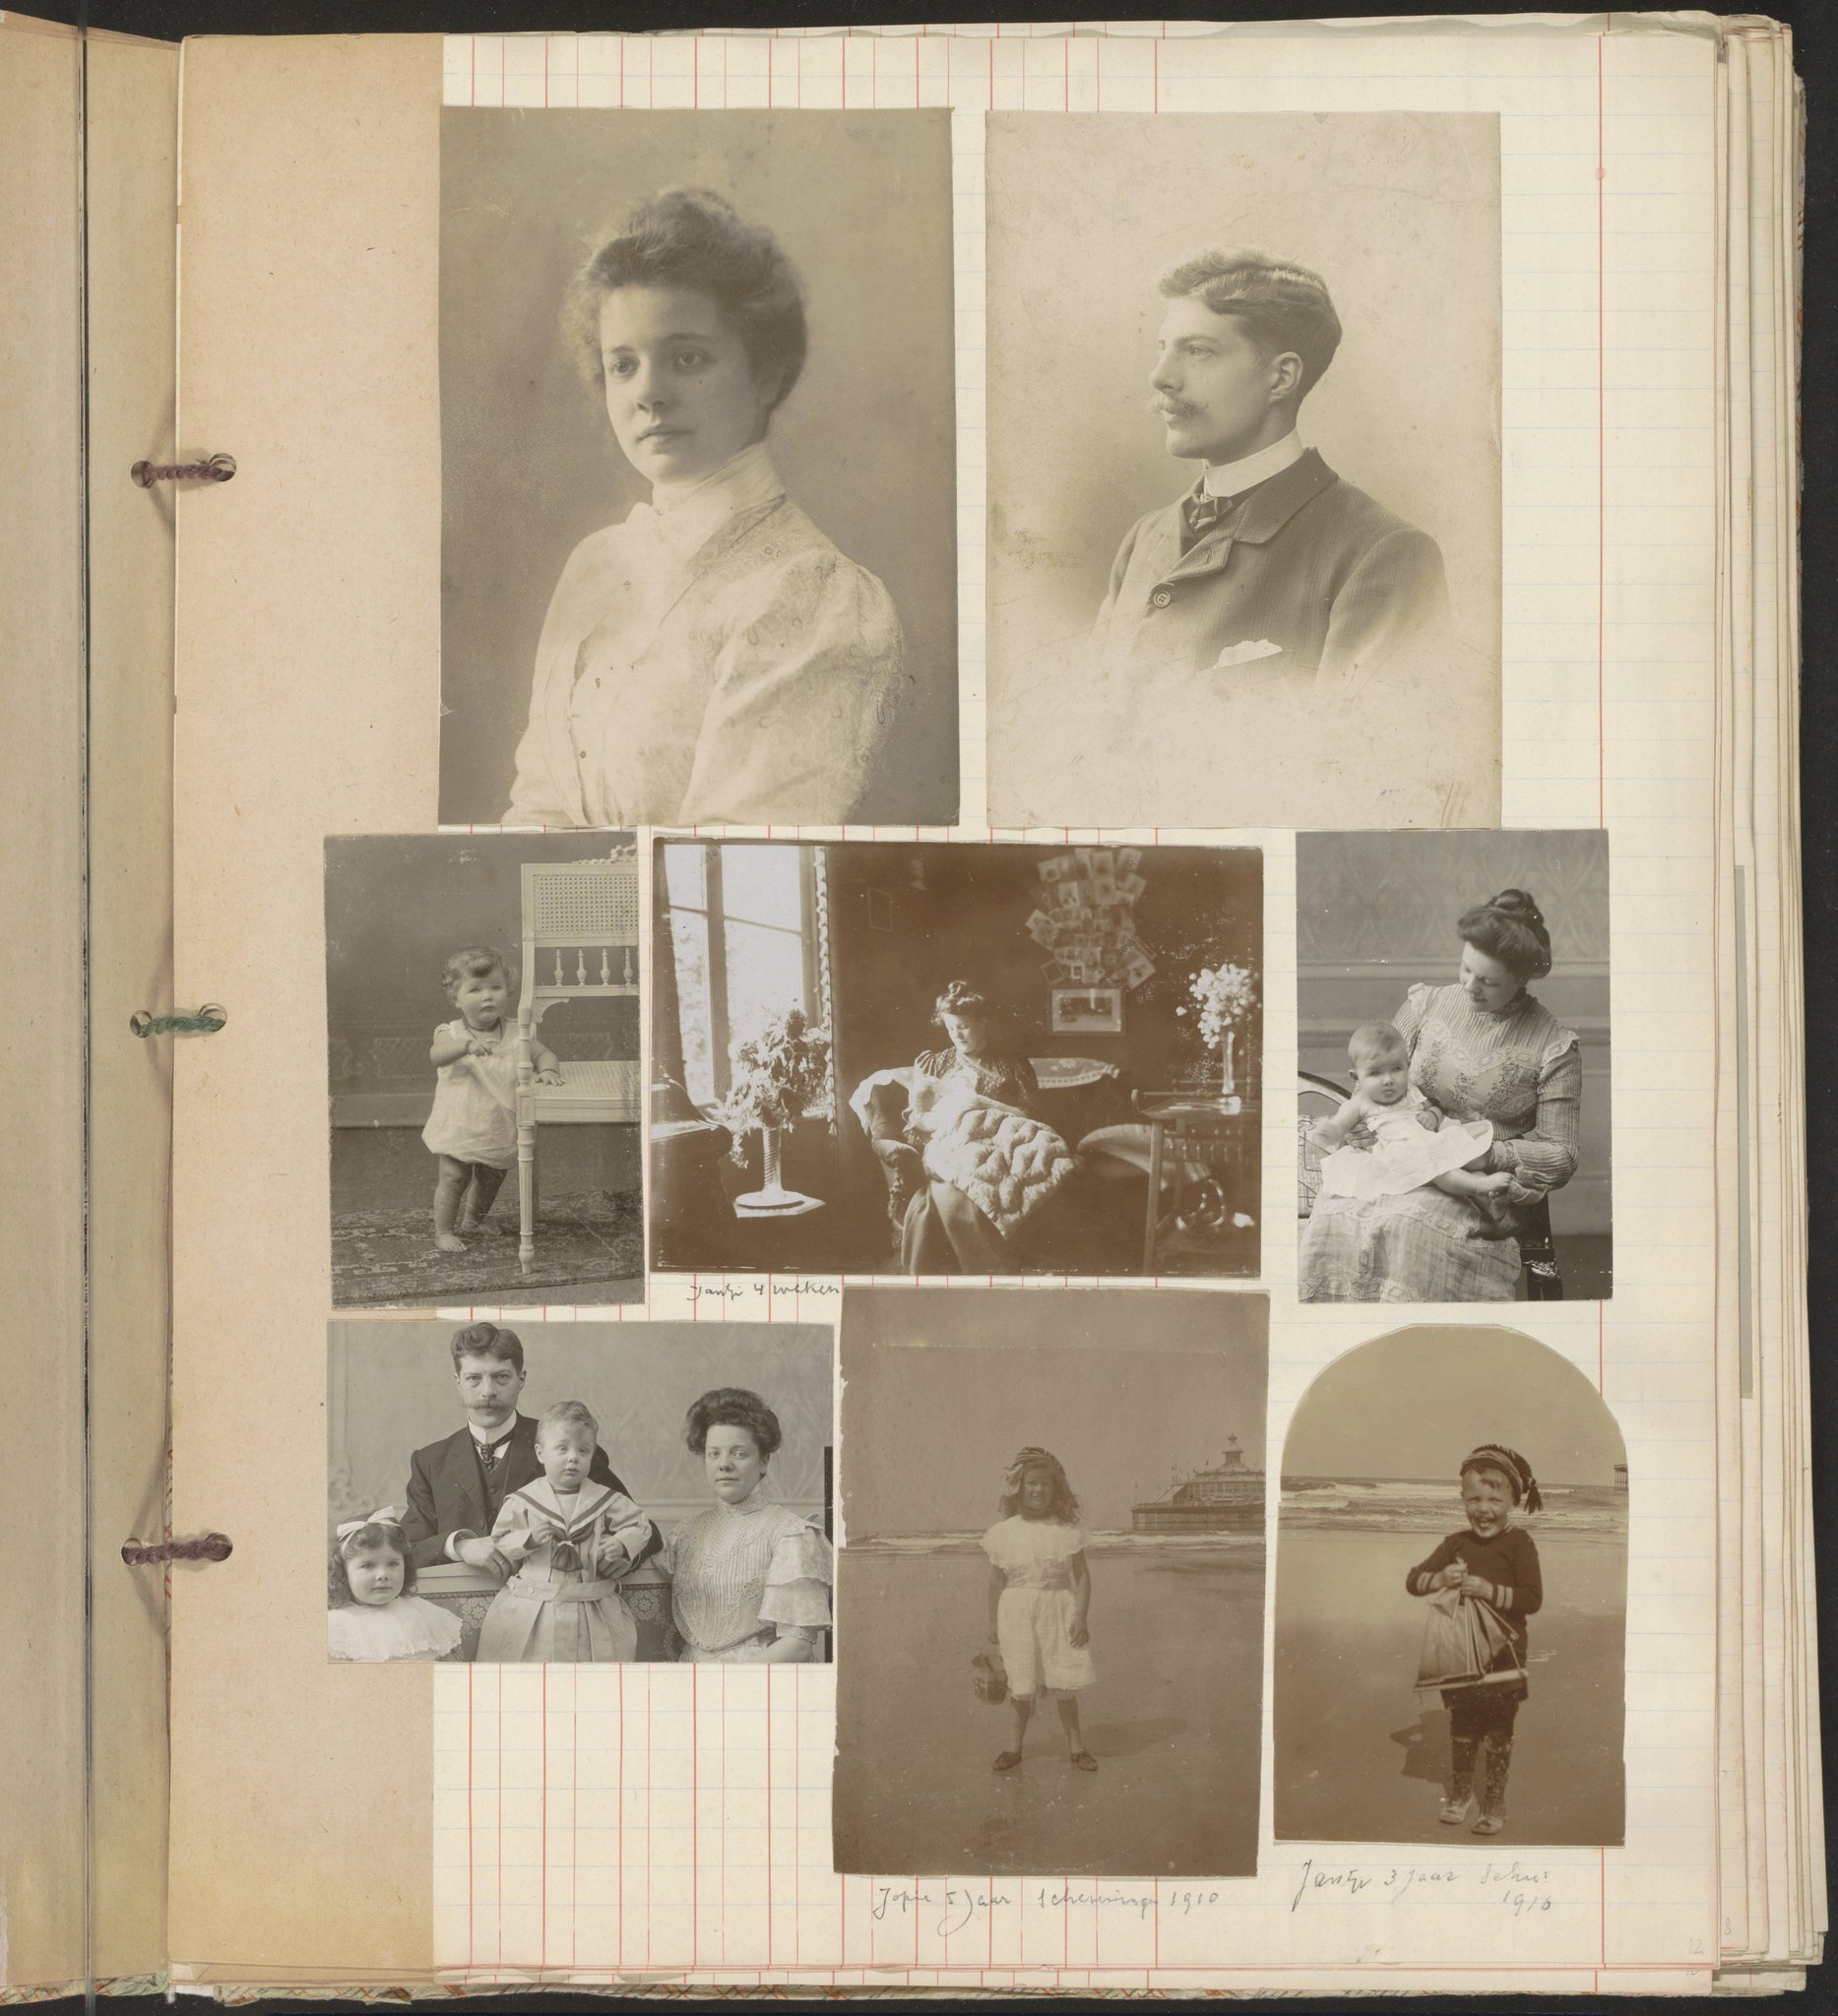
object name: photograph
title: Portretten van onbekende personen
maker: Anonymous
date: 1907-1910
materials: paper, photographic support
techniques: gelatin silver print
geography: netherlands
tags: adult woman, adult man, child, mother and baby or young child, beach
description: Albumblad met portretten van een echtpaar en kinderen, op verschillende momenten in hun leven. Ook foto's van kinderen aan het Scheveningse strand. De namen die genoemd worden zijn 'Jantje'en 'Jopie'. Onderdeel van Fotoalbum van de familie Petri.